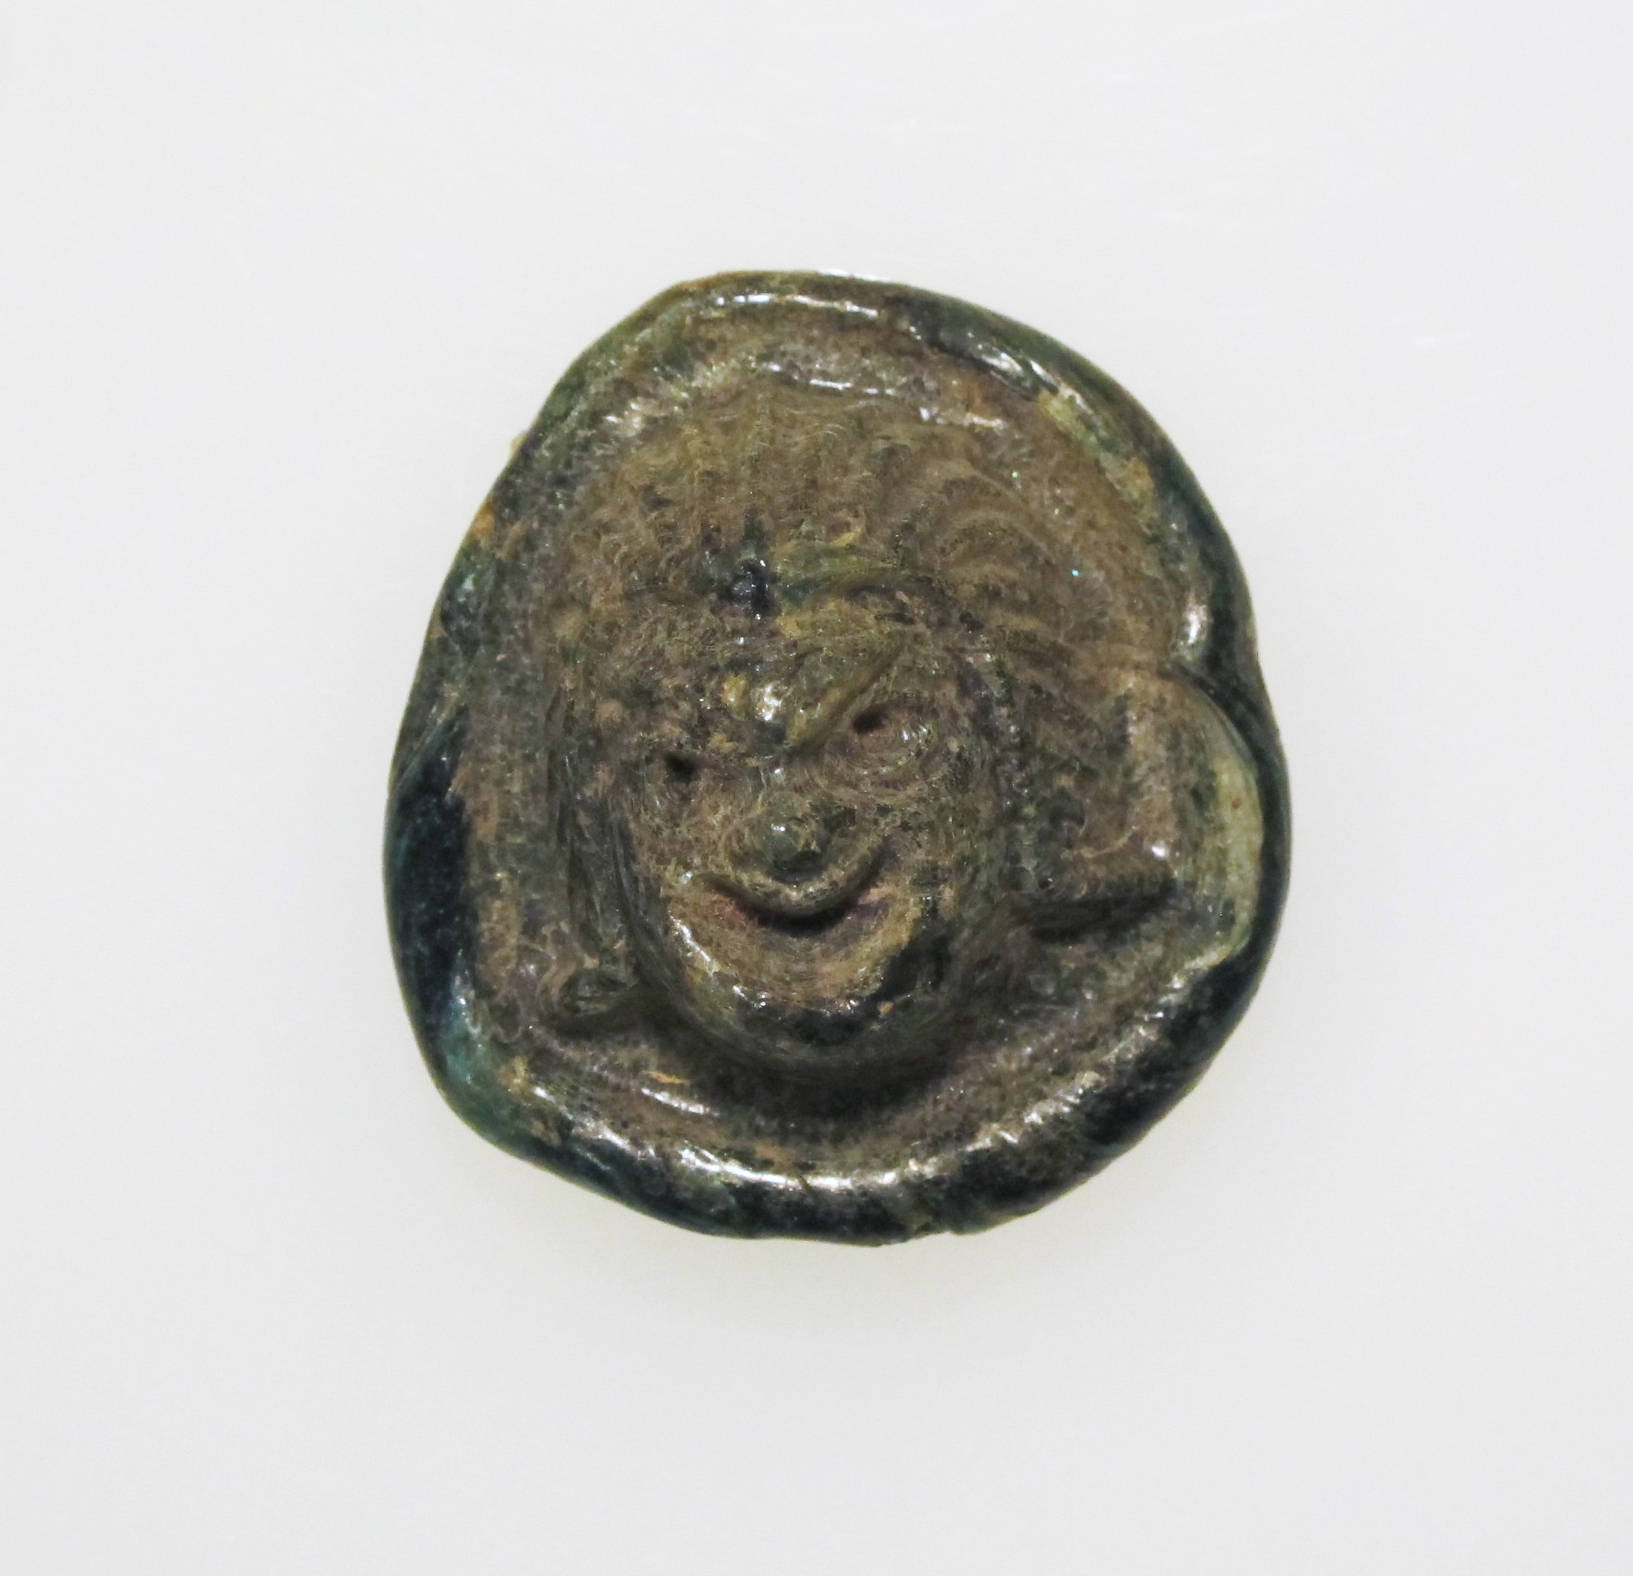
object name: appliqué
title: Glass appliqué with theatrical mask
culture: roman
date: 101-400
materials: glass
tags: masks